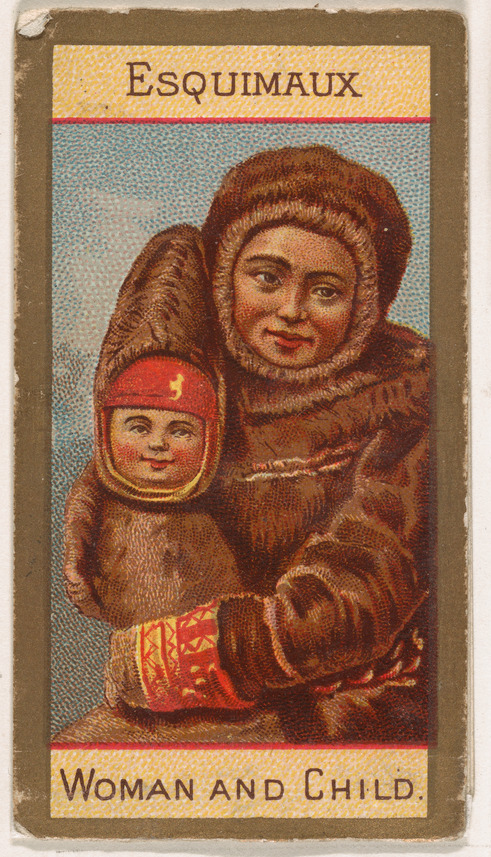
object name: print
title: Esquimaux, Woman and Child, from Types of Nationalities (N240) issued by Kinney Bros.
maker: kinney brothers tobacco company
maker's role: publisher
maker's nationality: american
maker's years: 1869-2011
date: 1890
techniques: color lithograph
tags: infants,women